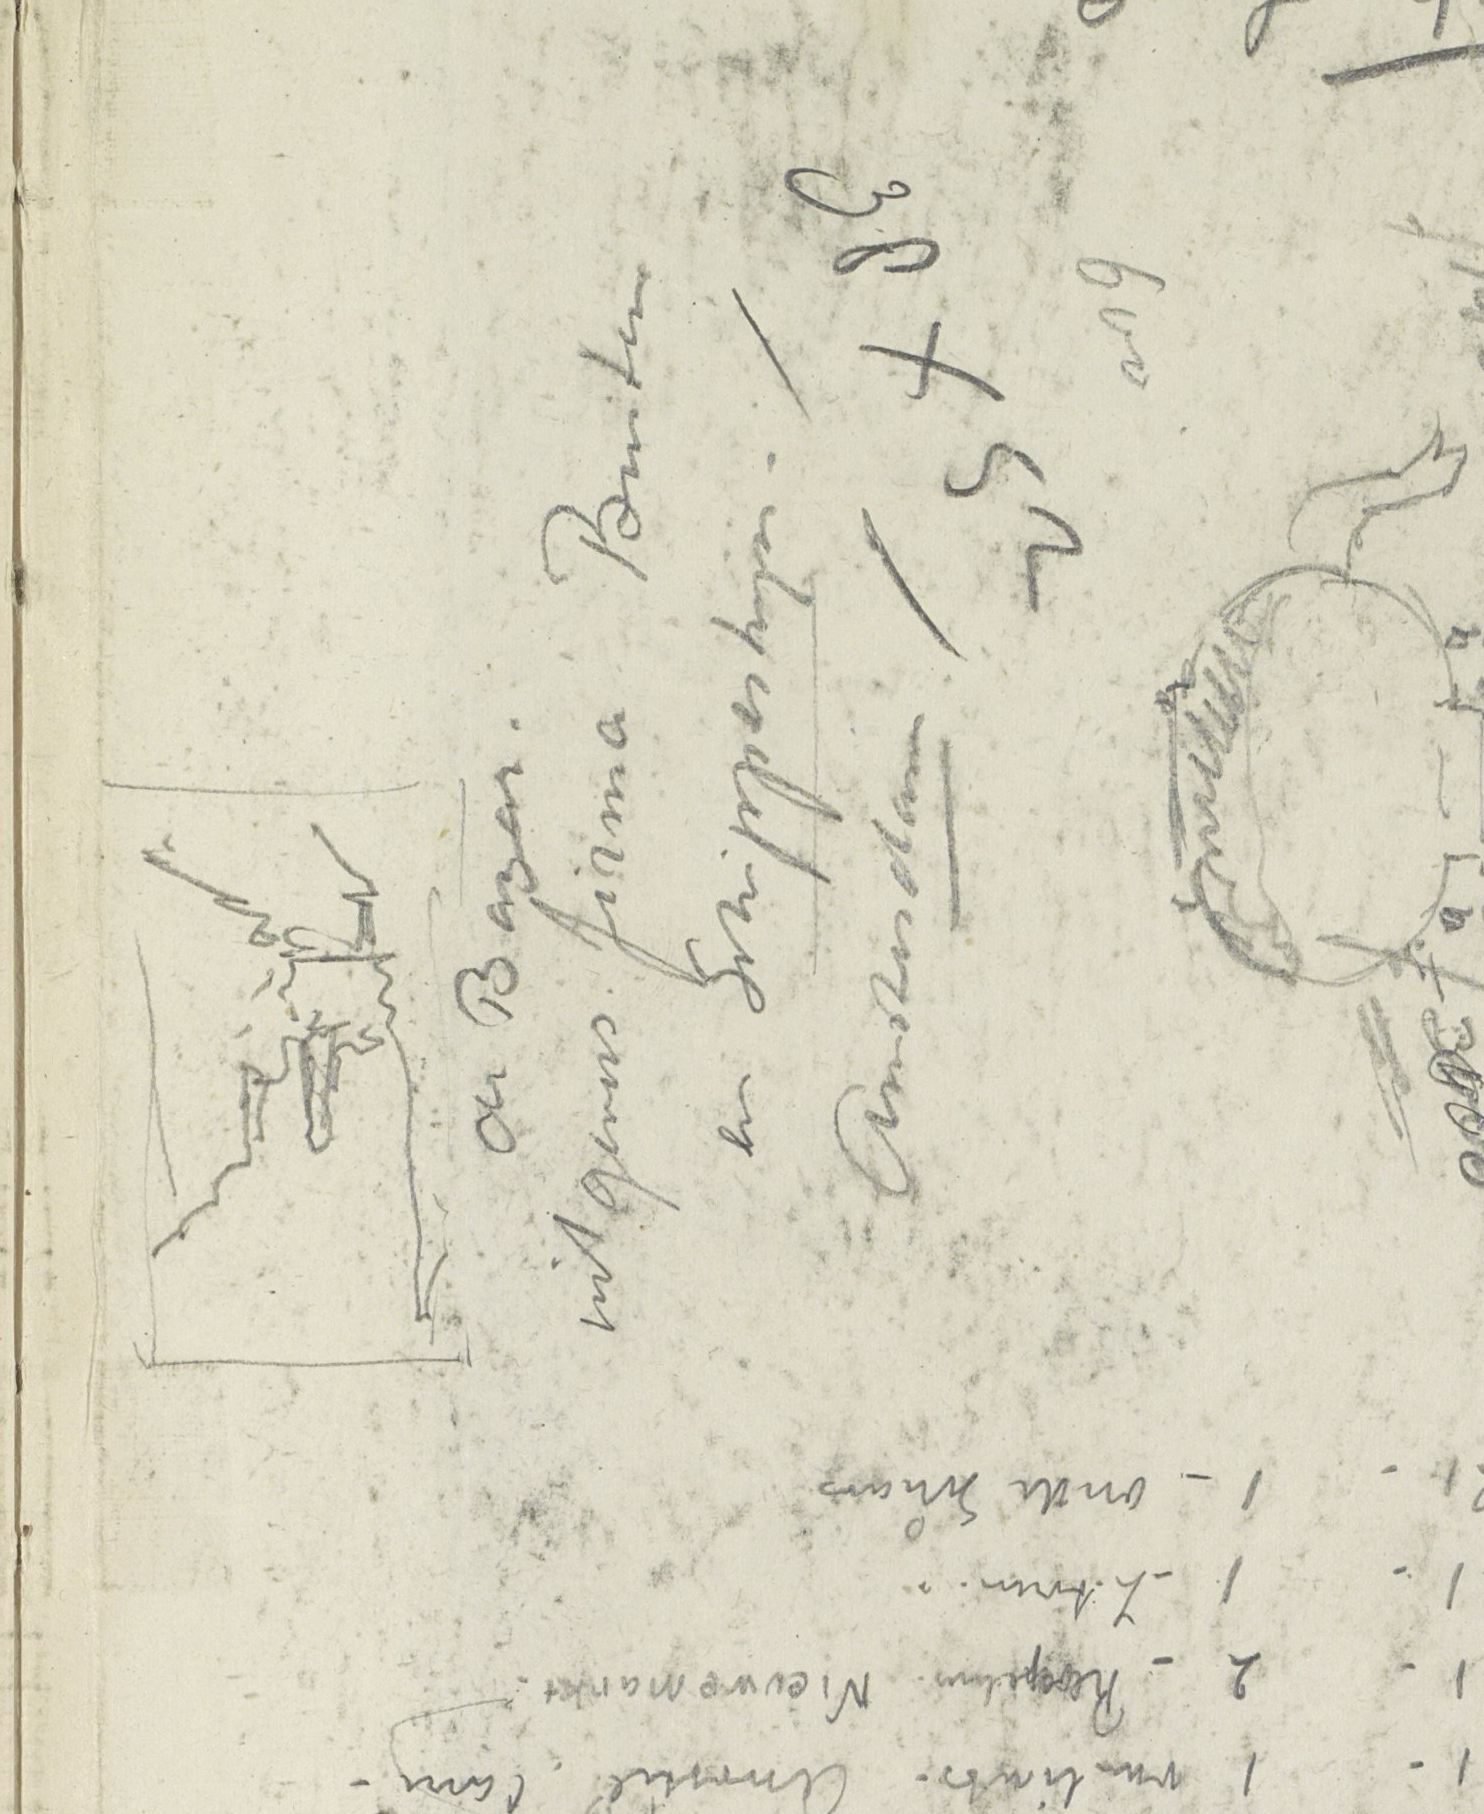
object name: sketchbook leaf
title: Theepot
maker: cornelis vreedenburgh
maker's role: draughtsman, print maker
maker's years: 1880-1946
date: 1890-1946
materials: paper, pencil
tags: tea-pot; samovar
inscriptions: annotation: ‘[...]’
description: Achterste schutblad uit een schetsboek met 76 bladen.